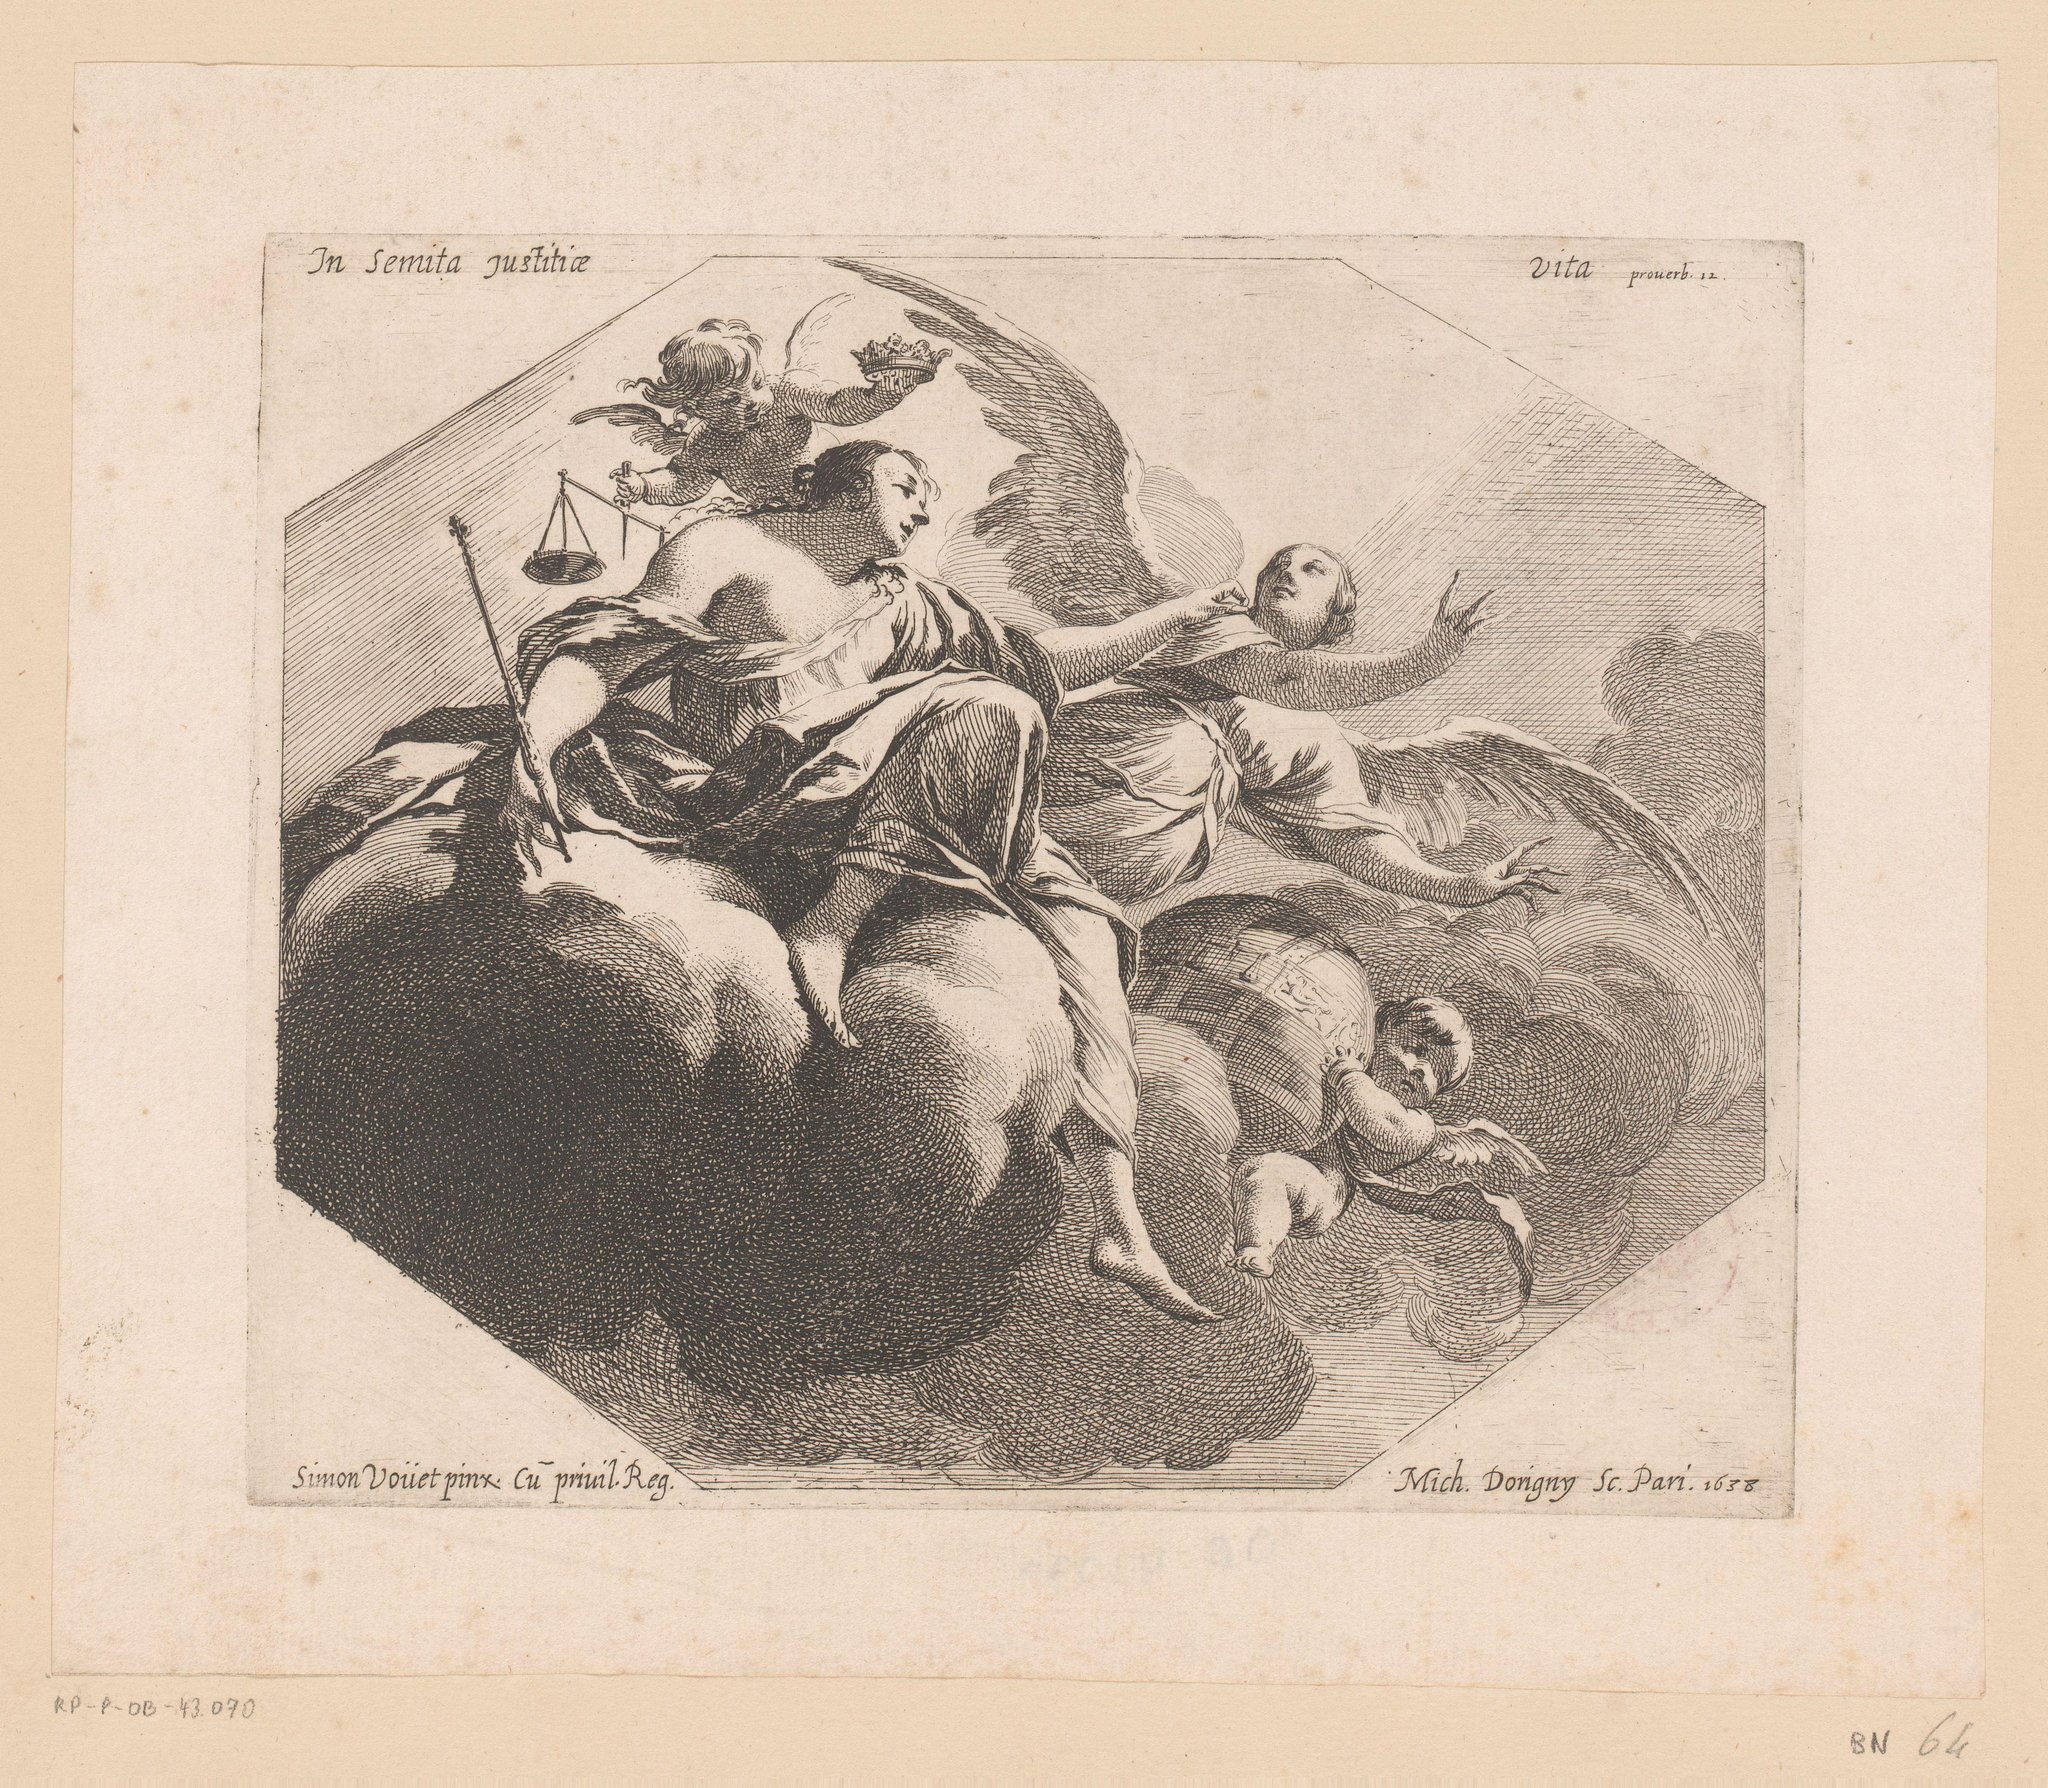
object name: print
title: In Semita Justitiae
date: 1638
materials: paper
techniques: engraving, etching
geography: france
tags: justice, 'justitia'; 'giustitia divina' (ripa) ~ one of the four cardinal virtues, assemblies of the gods in the air, possibly on the clouds, angels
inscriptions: collector's mark: Lugt 230